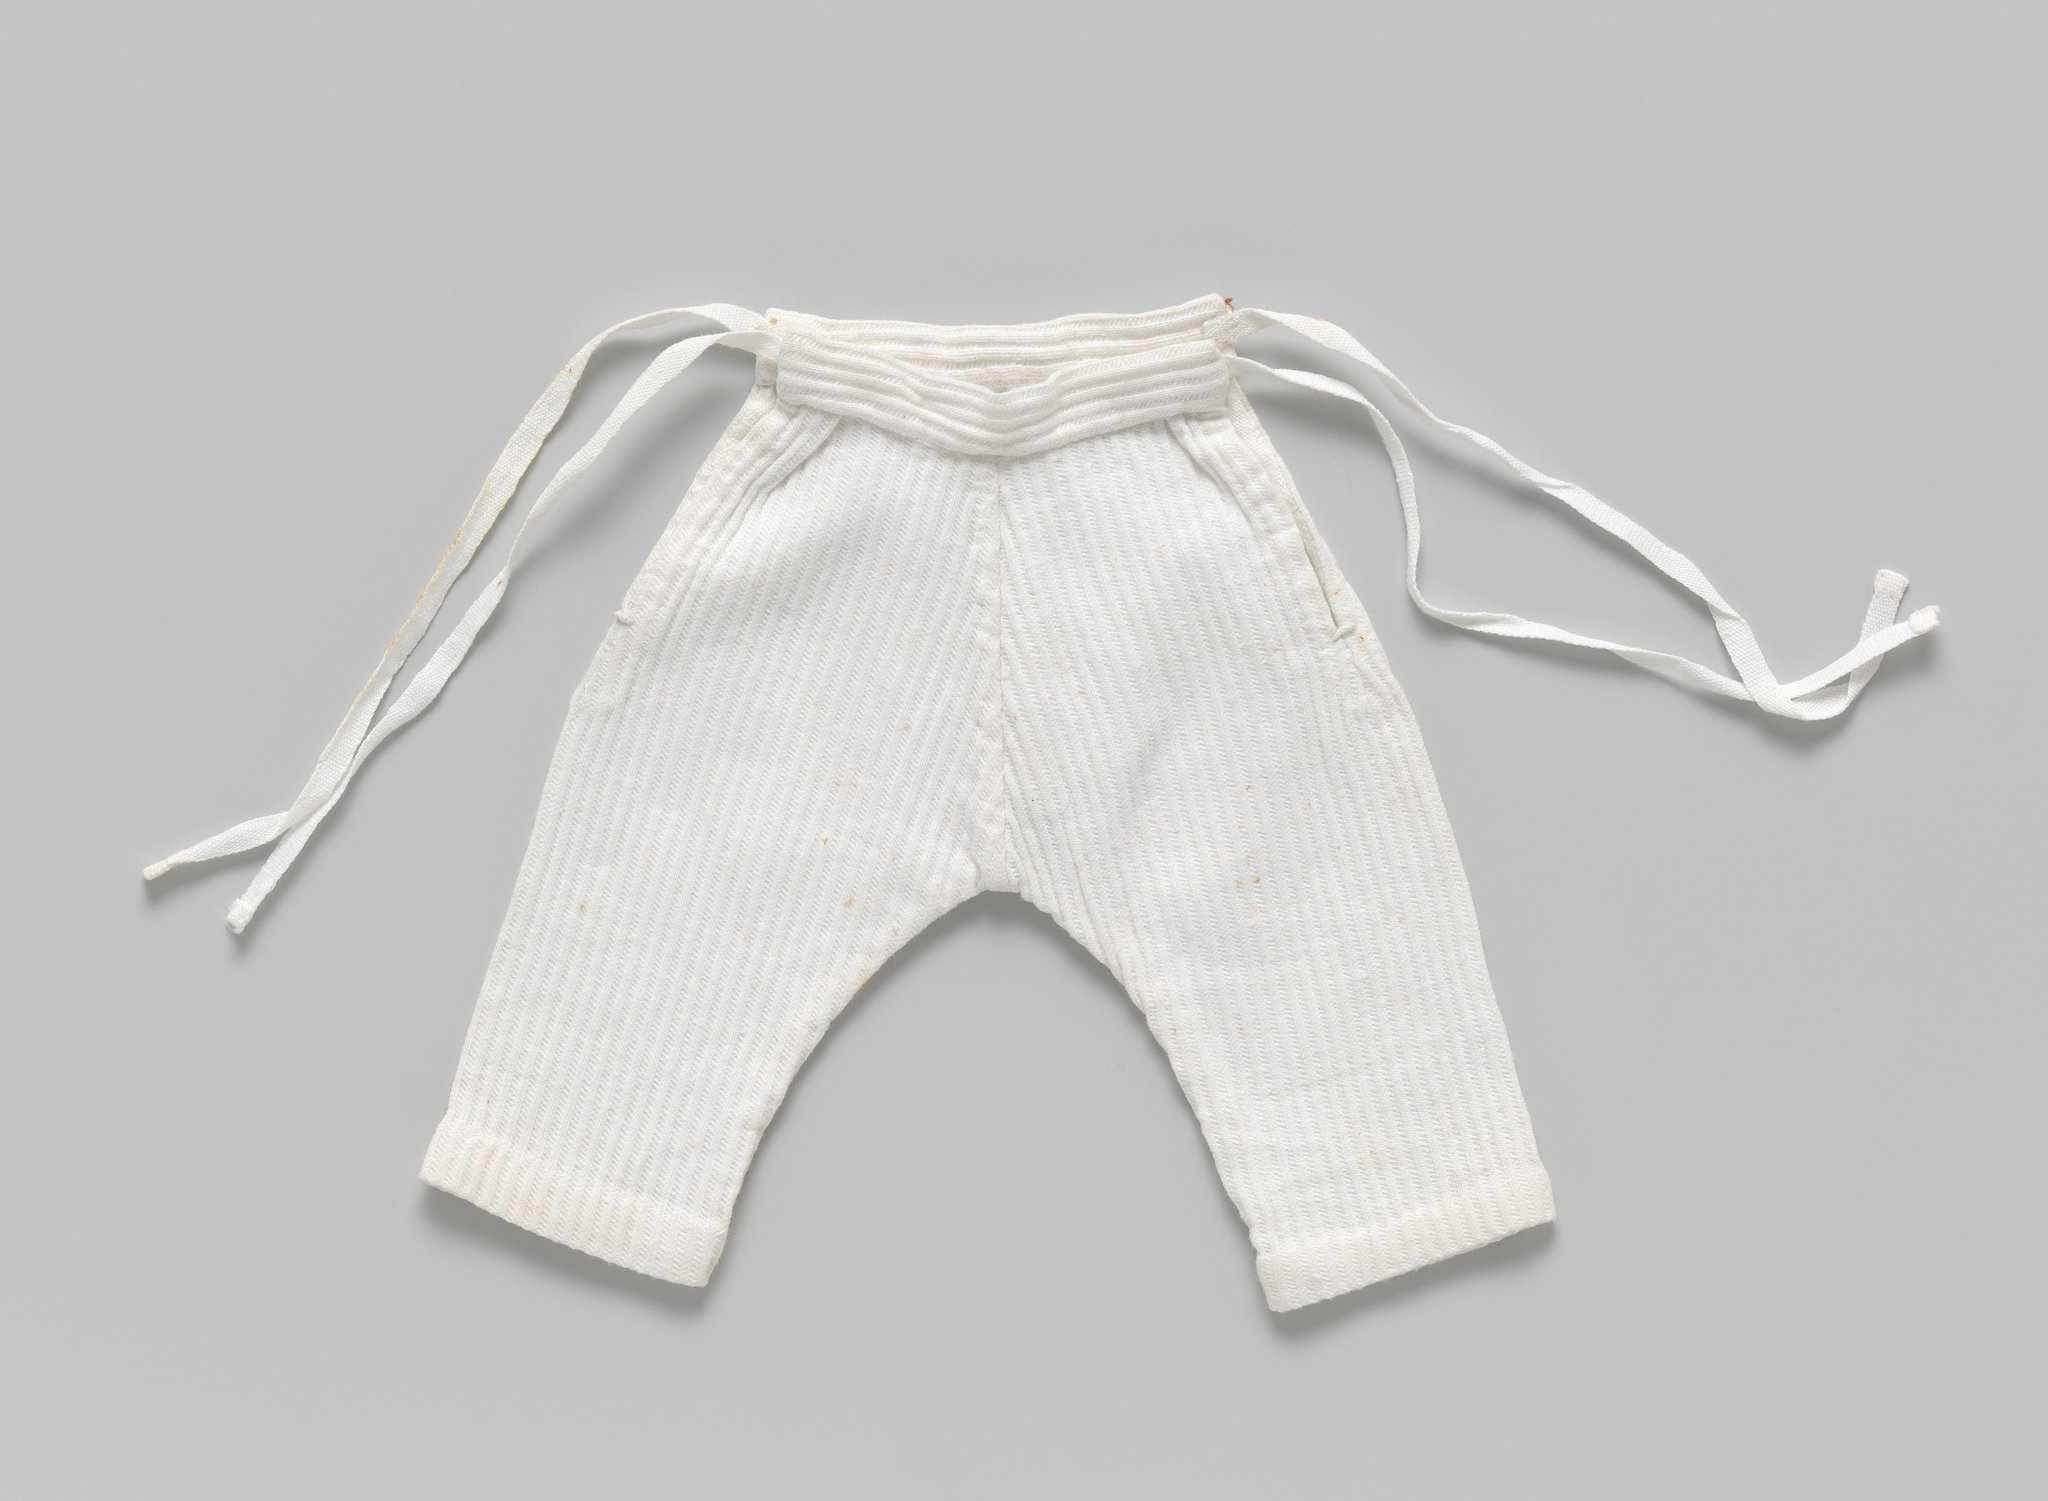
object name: pant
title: Broek van piqué, met lange pijpen en met banden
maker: p. titjen-baas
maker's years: 1900-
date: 1910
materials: cotton, textile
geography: netherlands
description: Broek van piqué , met lange pijpen en met banden. Behorend bij pop "LILLY".